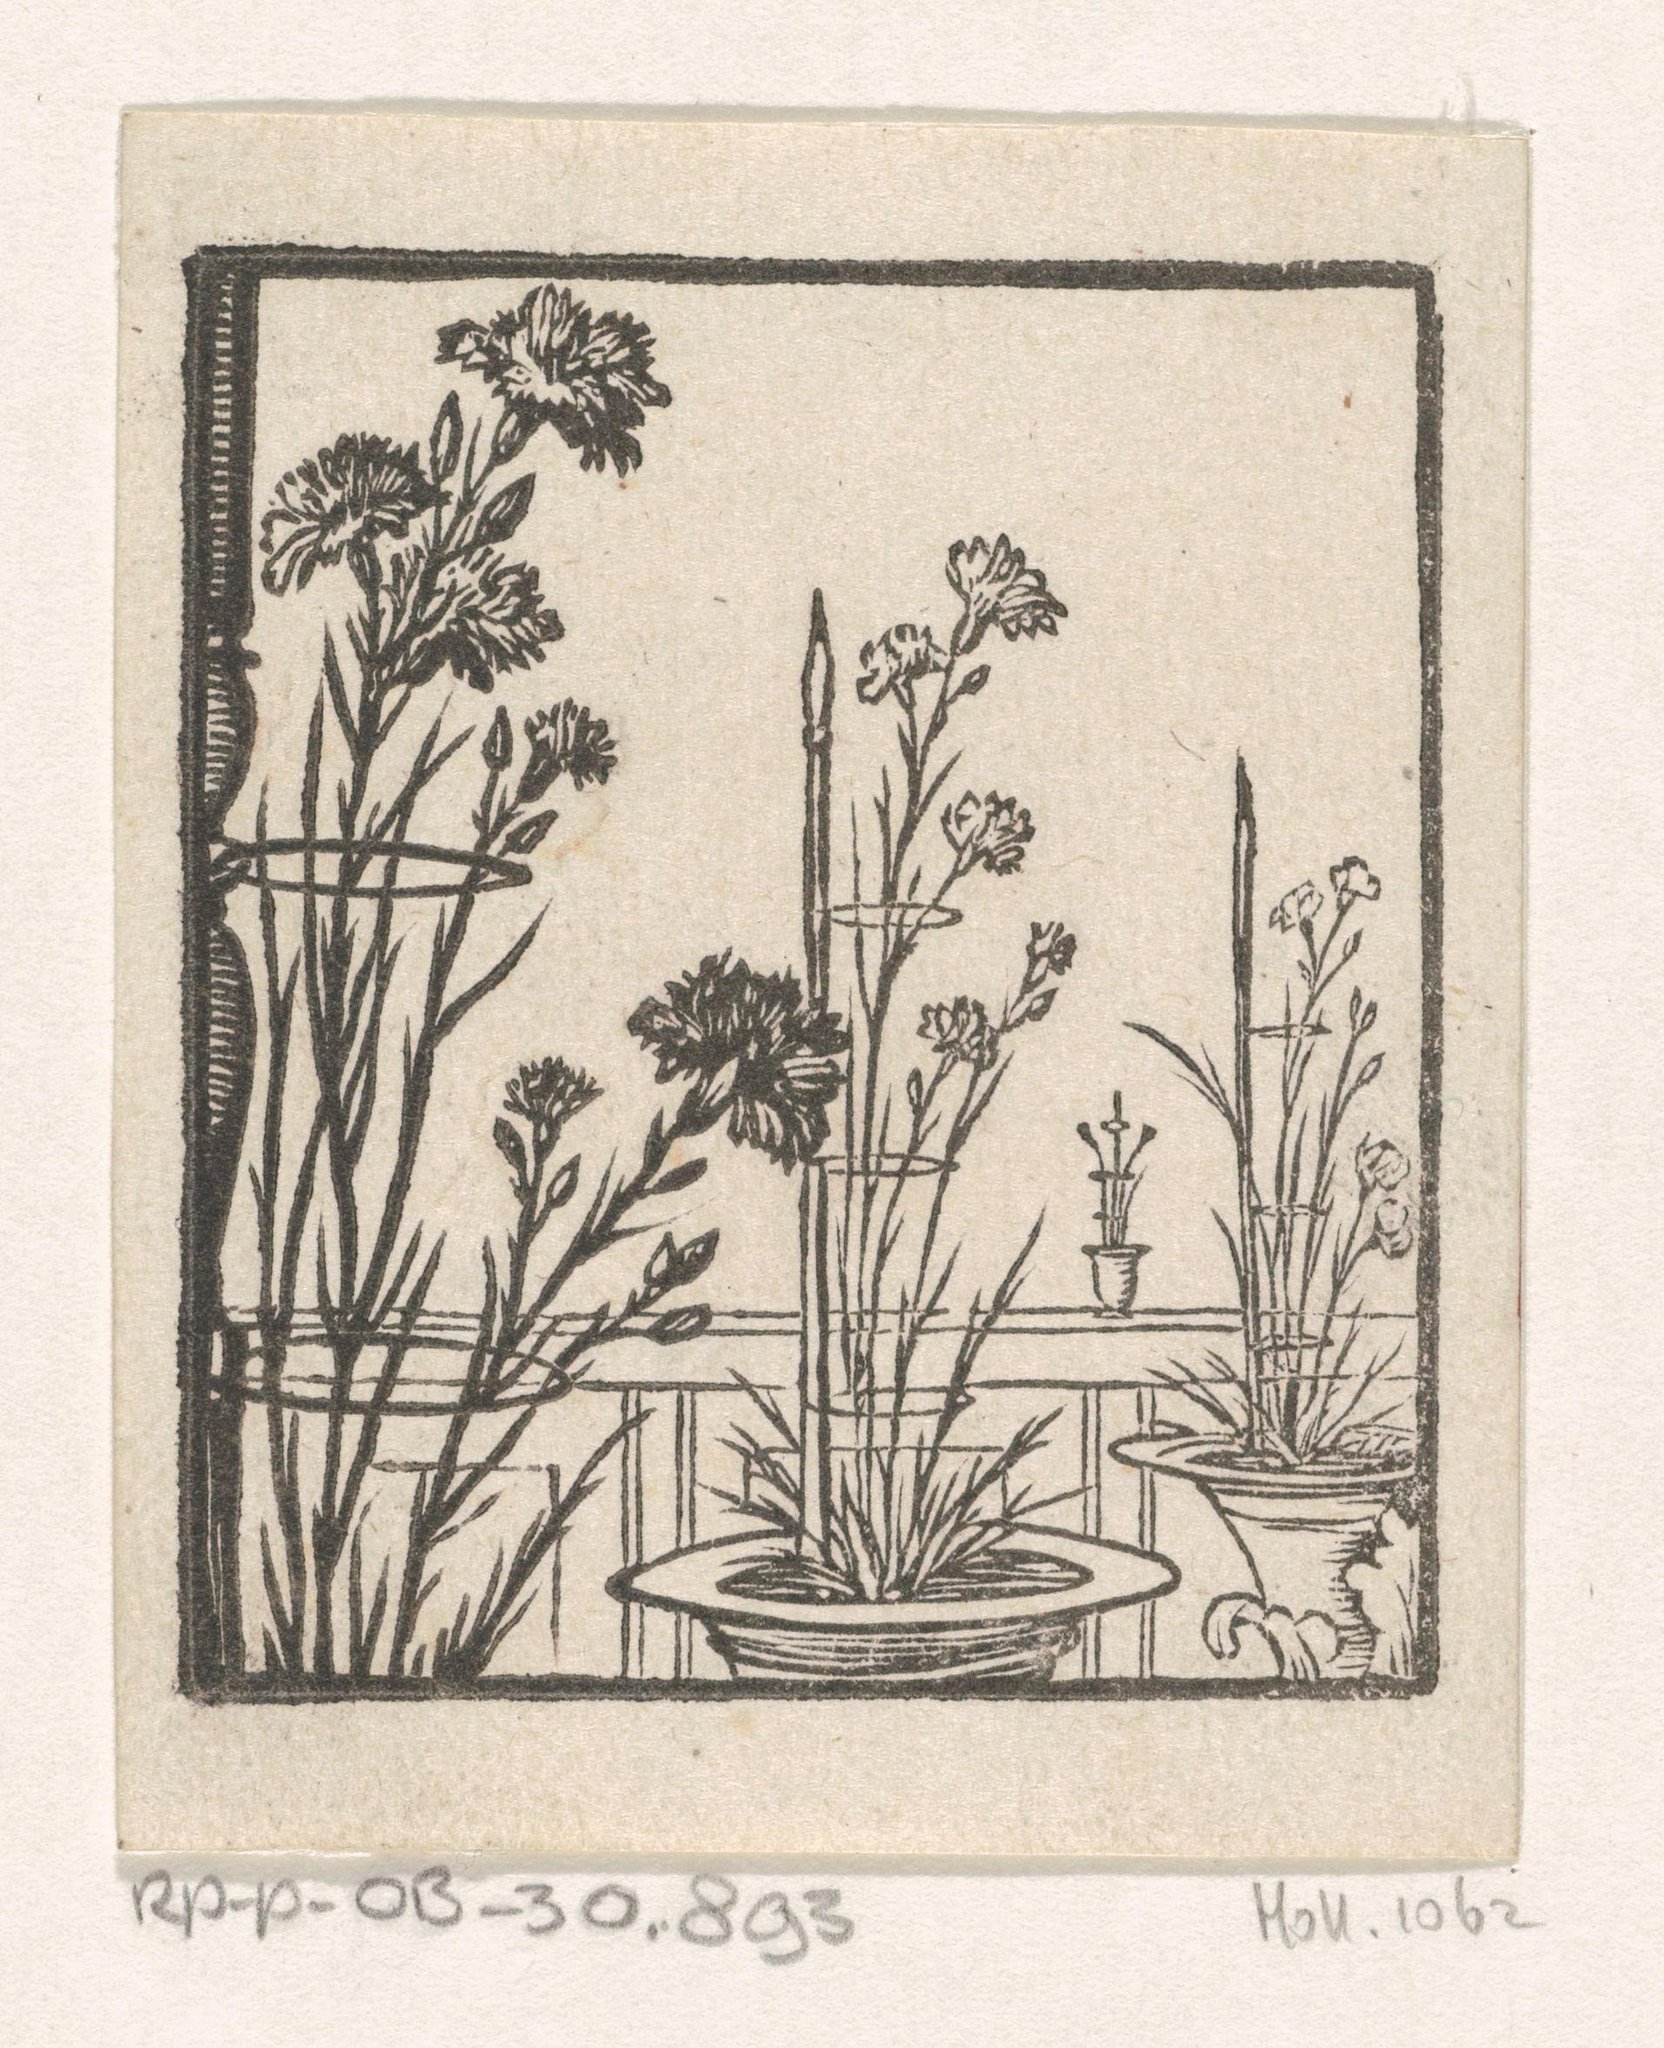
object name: print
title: Potten met anjeliers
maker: isaac vincentsz. van der vinne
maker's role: draughtsman, print maker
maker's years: 1665-1740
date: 1681-1740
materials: paper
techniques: woodcut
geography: haarlem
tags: flowers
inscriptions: collector's mark: Lugt 240